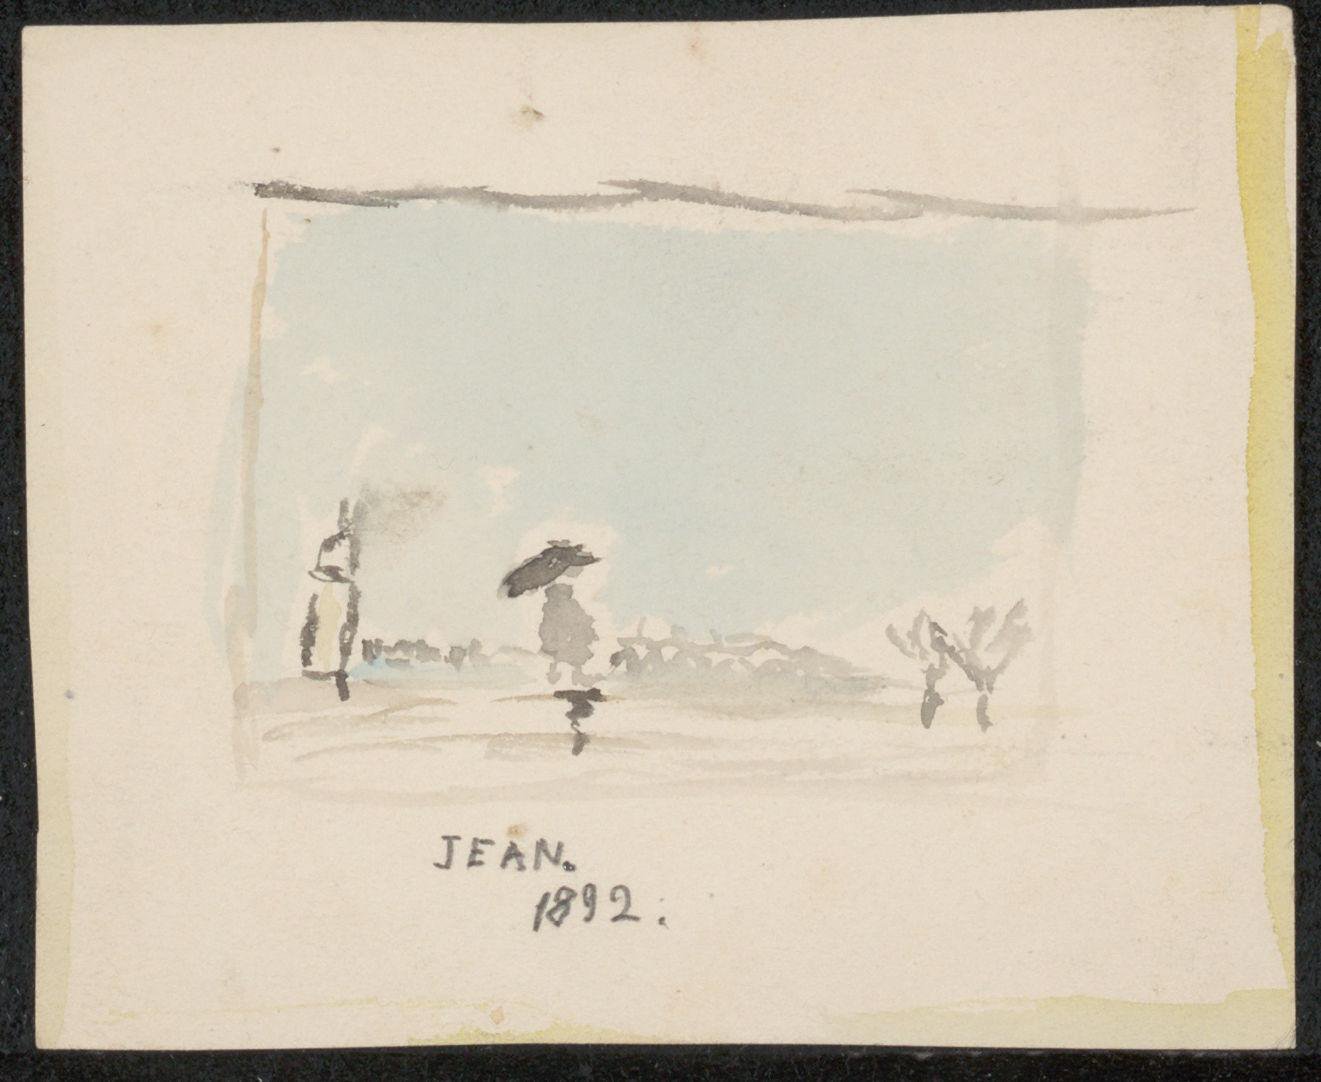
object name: letter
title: Brief aan Philip Zilcken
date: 1892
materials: ink, paper, pencil, watercolor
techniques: brush, writing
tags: the hague, painter, draughtsman, philip zilcken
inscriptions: collector's mark: ‘RPK’